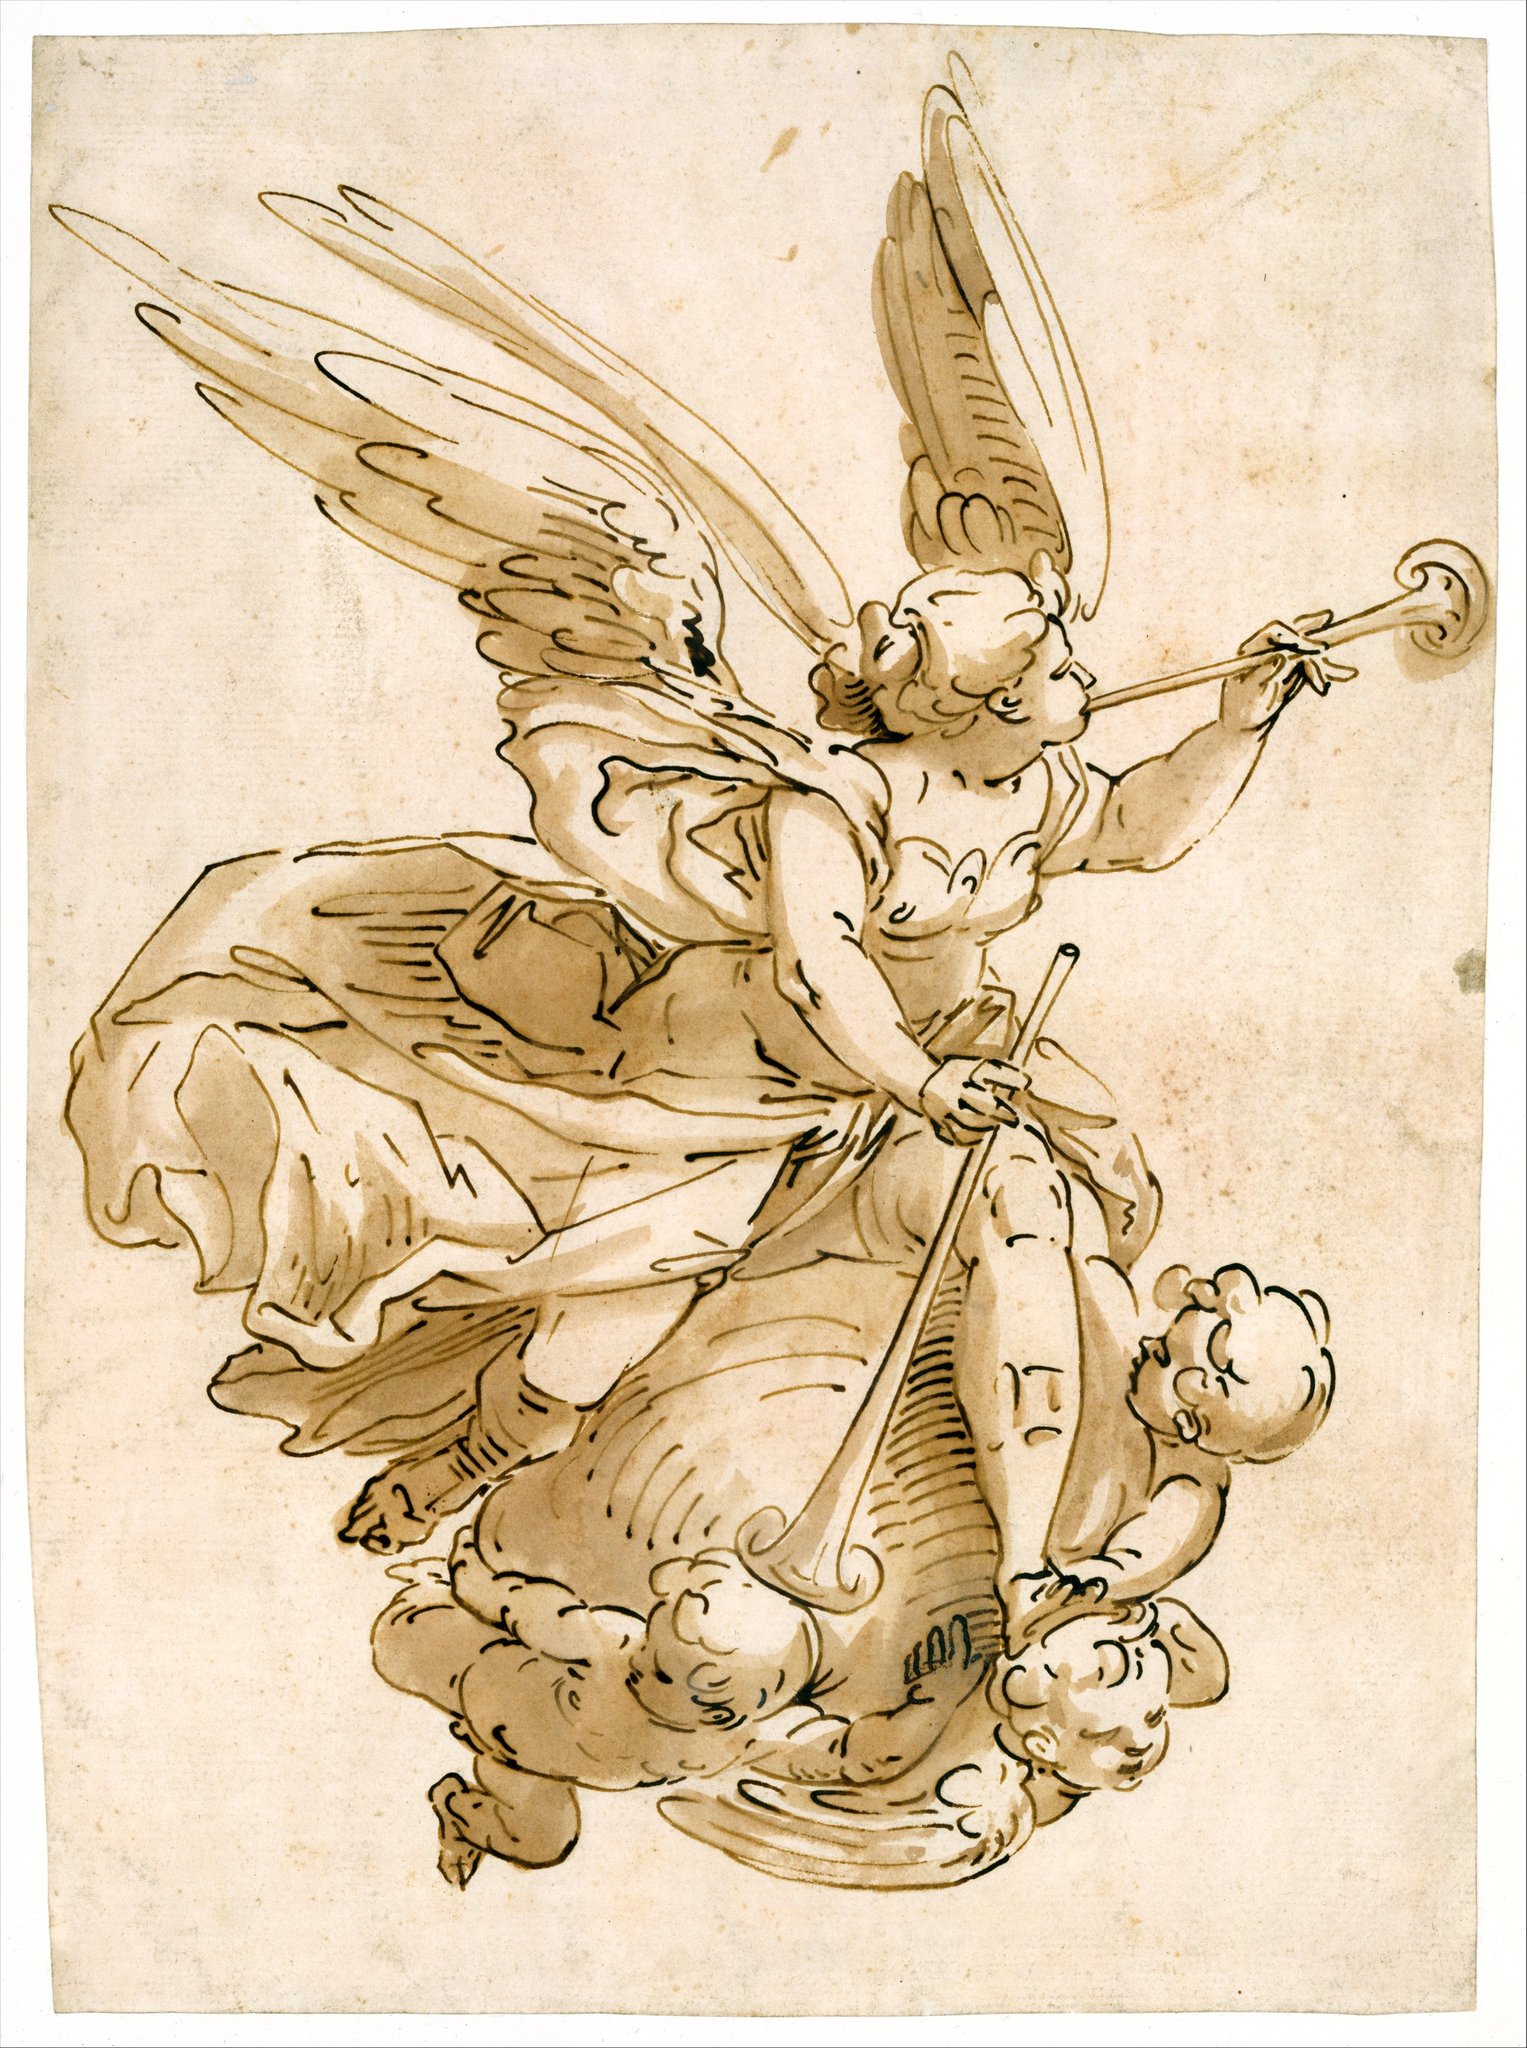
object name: drawing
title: Fame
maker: luca cambiaso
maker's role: artist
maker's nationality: italian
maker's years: 1527-1585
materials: chalk, ink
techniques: pen, wash